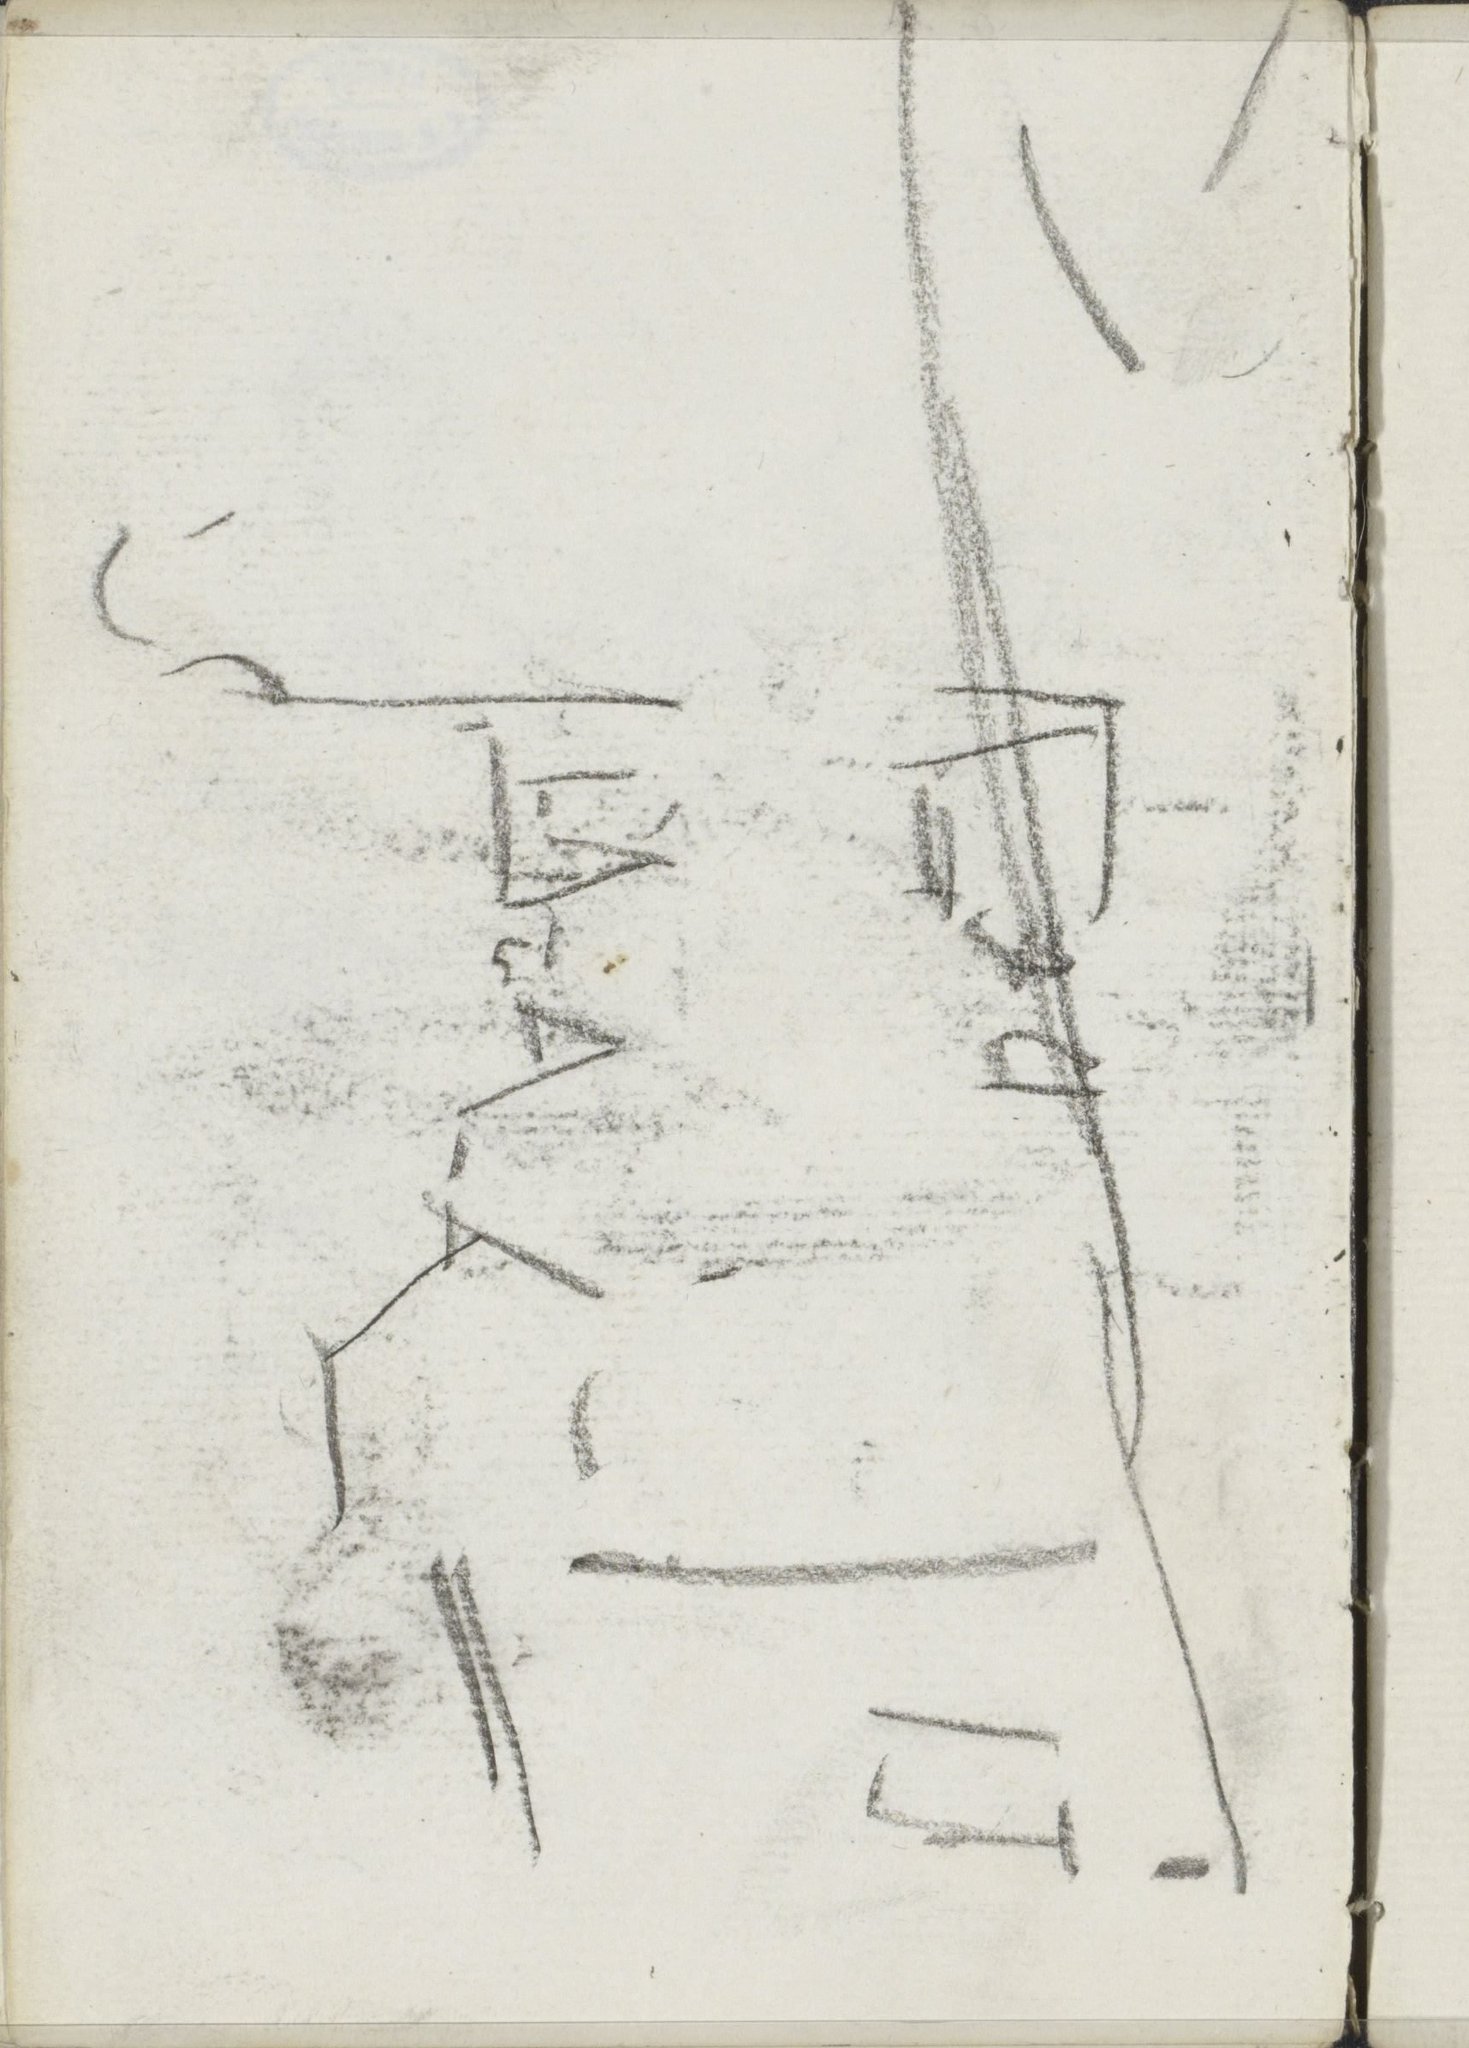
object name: sketchbook leaf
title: Gezicht in Amsterdam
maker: george hendrik breitner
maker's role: draughtsman, painter, print maker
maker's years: 1857-1923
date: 1891-1894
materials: chalk, paper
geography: amsterdam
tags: city-view, and landscape with man-made constructions, civic architecture; edifices; dwellings, amsterdam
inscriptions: workshop stamp: Lugt 291d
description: Pagina 21 uit een schetsboek met 15 bladen.